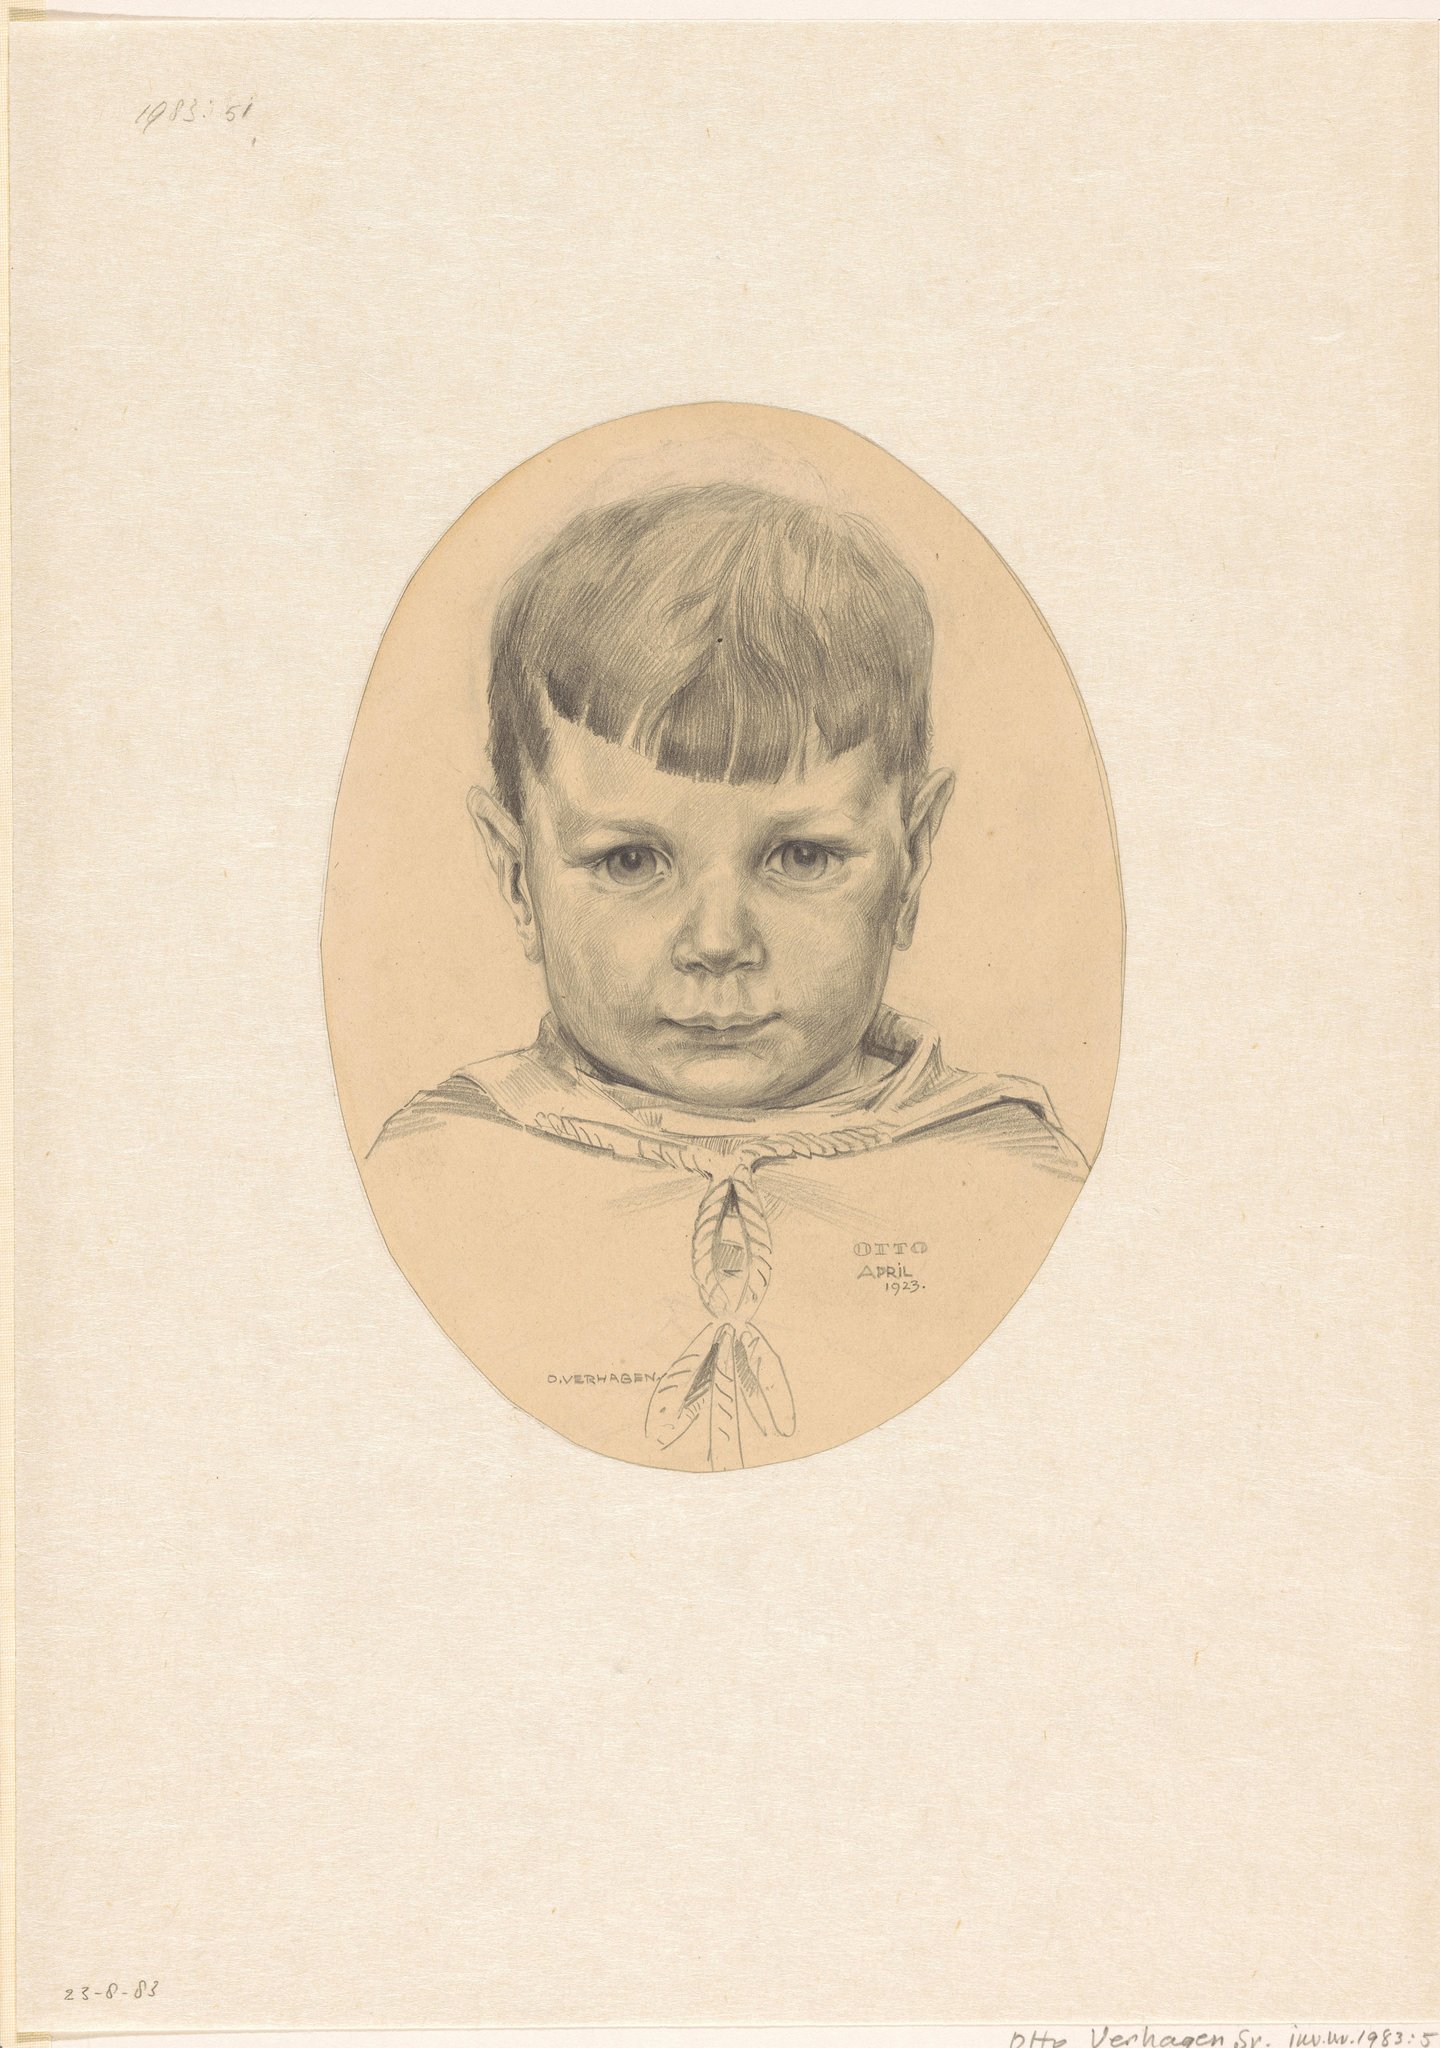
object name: drawing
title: Otto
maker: otto verhagen (i)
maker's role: draughtsman, print maker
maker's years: 1885-1951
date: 1904-1923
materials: paper, pencil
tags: maarssen, painter, print maker, draughtsman, otto verhagen (ii), historical persons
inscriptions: collector's mark: Lugt 2228